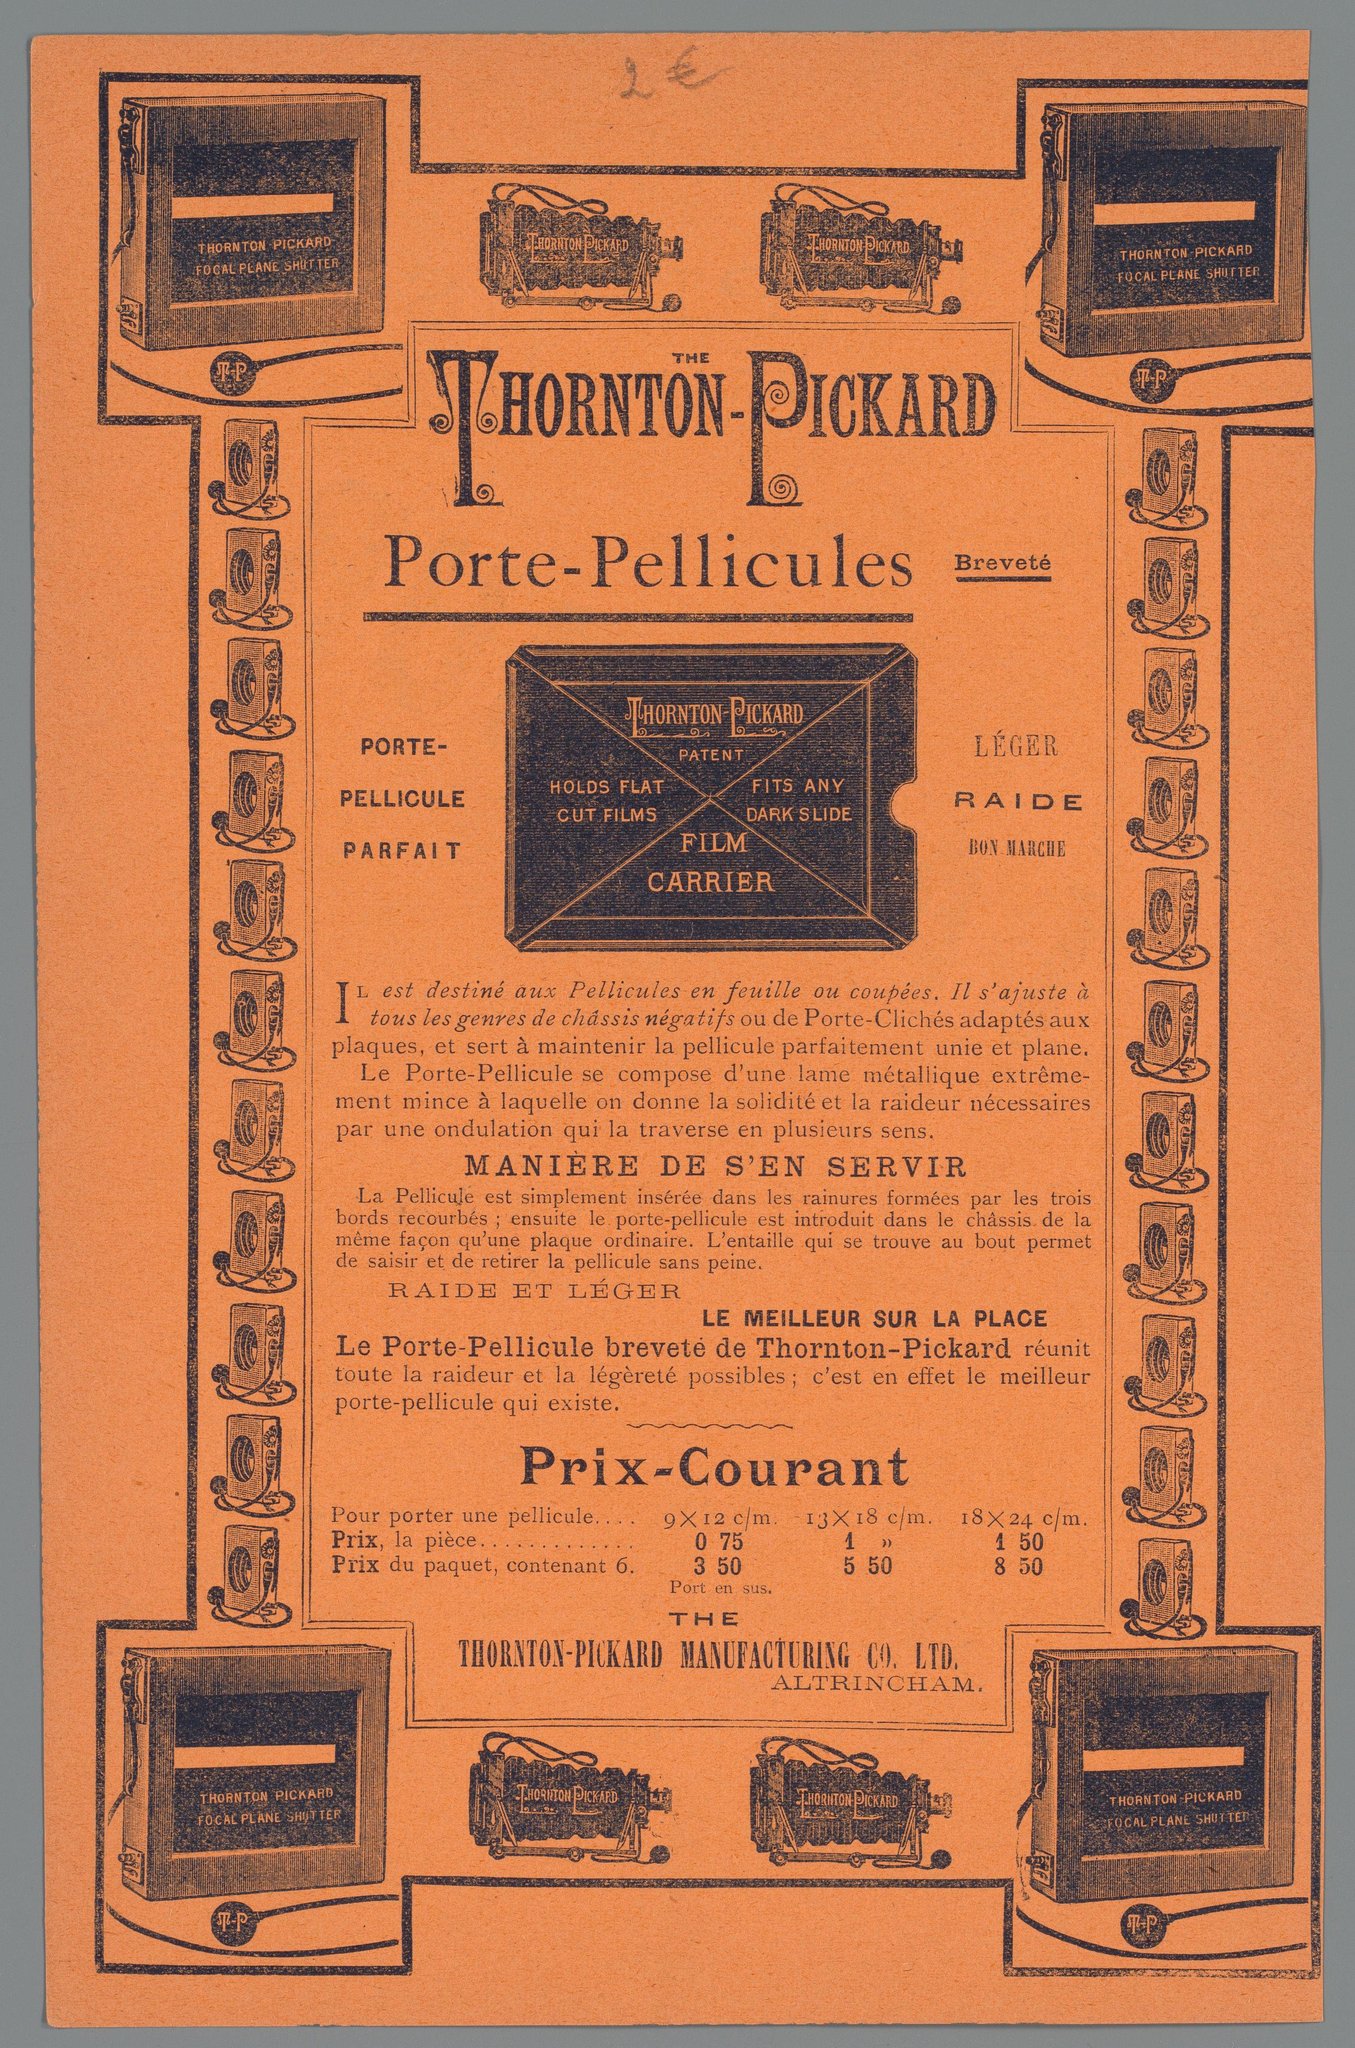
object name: advertisement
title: Advertentie voor filmhouders van Thornton-Pickard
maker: Anonymous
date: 1888-1900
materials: paper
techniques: letterpress printing, printing block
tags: camera ~ photography, printing ~ film, printed matter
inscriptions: inscription: ‘2€’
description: Advertentie voor filmhouders van de Britse camerafabrikant Thornton-Pickard uit Altrincham met op de achterzijde een advertentie voor fotopapieren van Tambour.